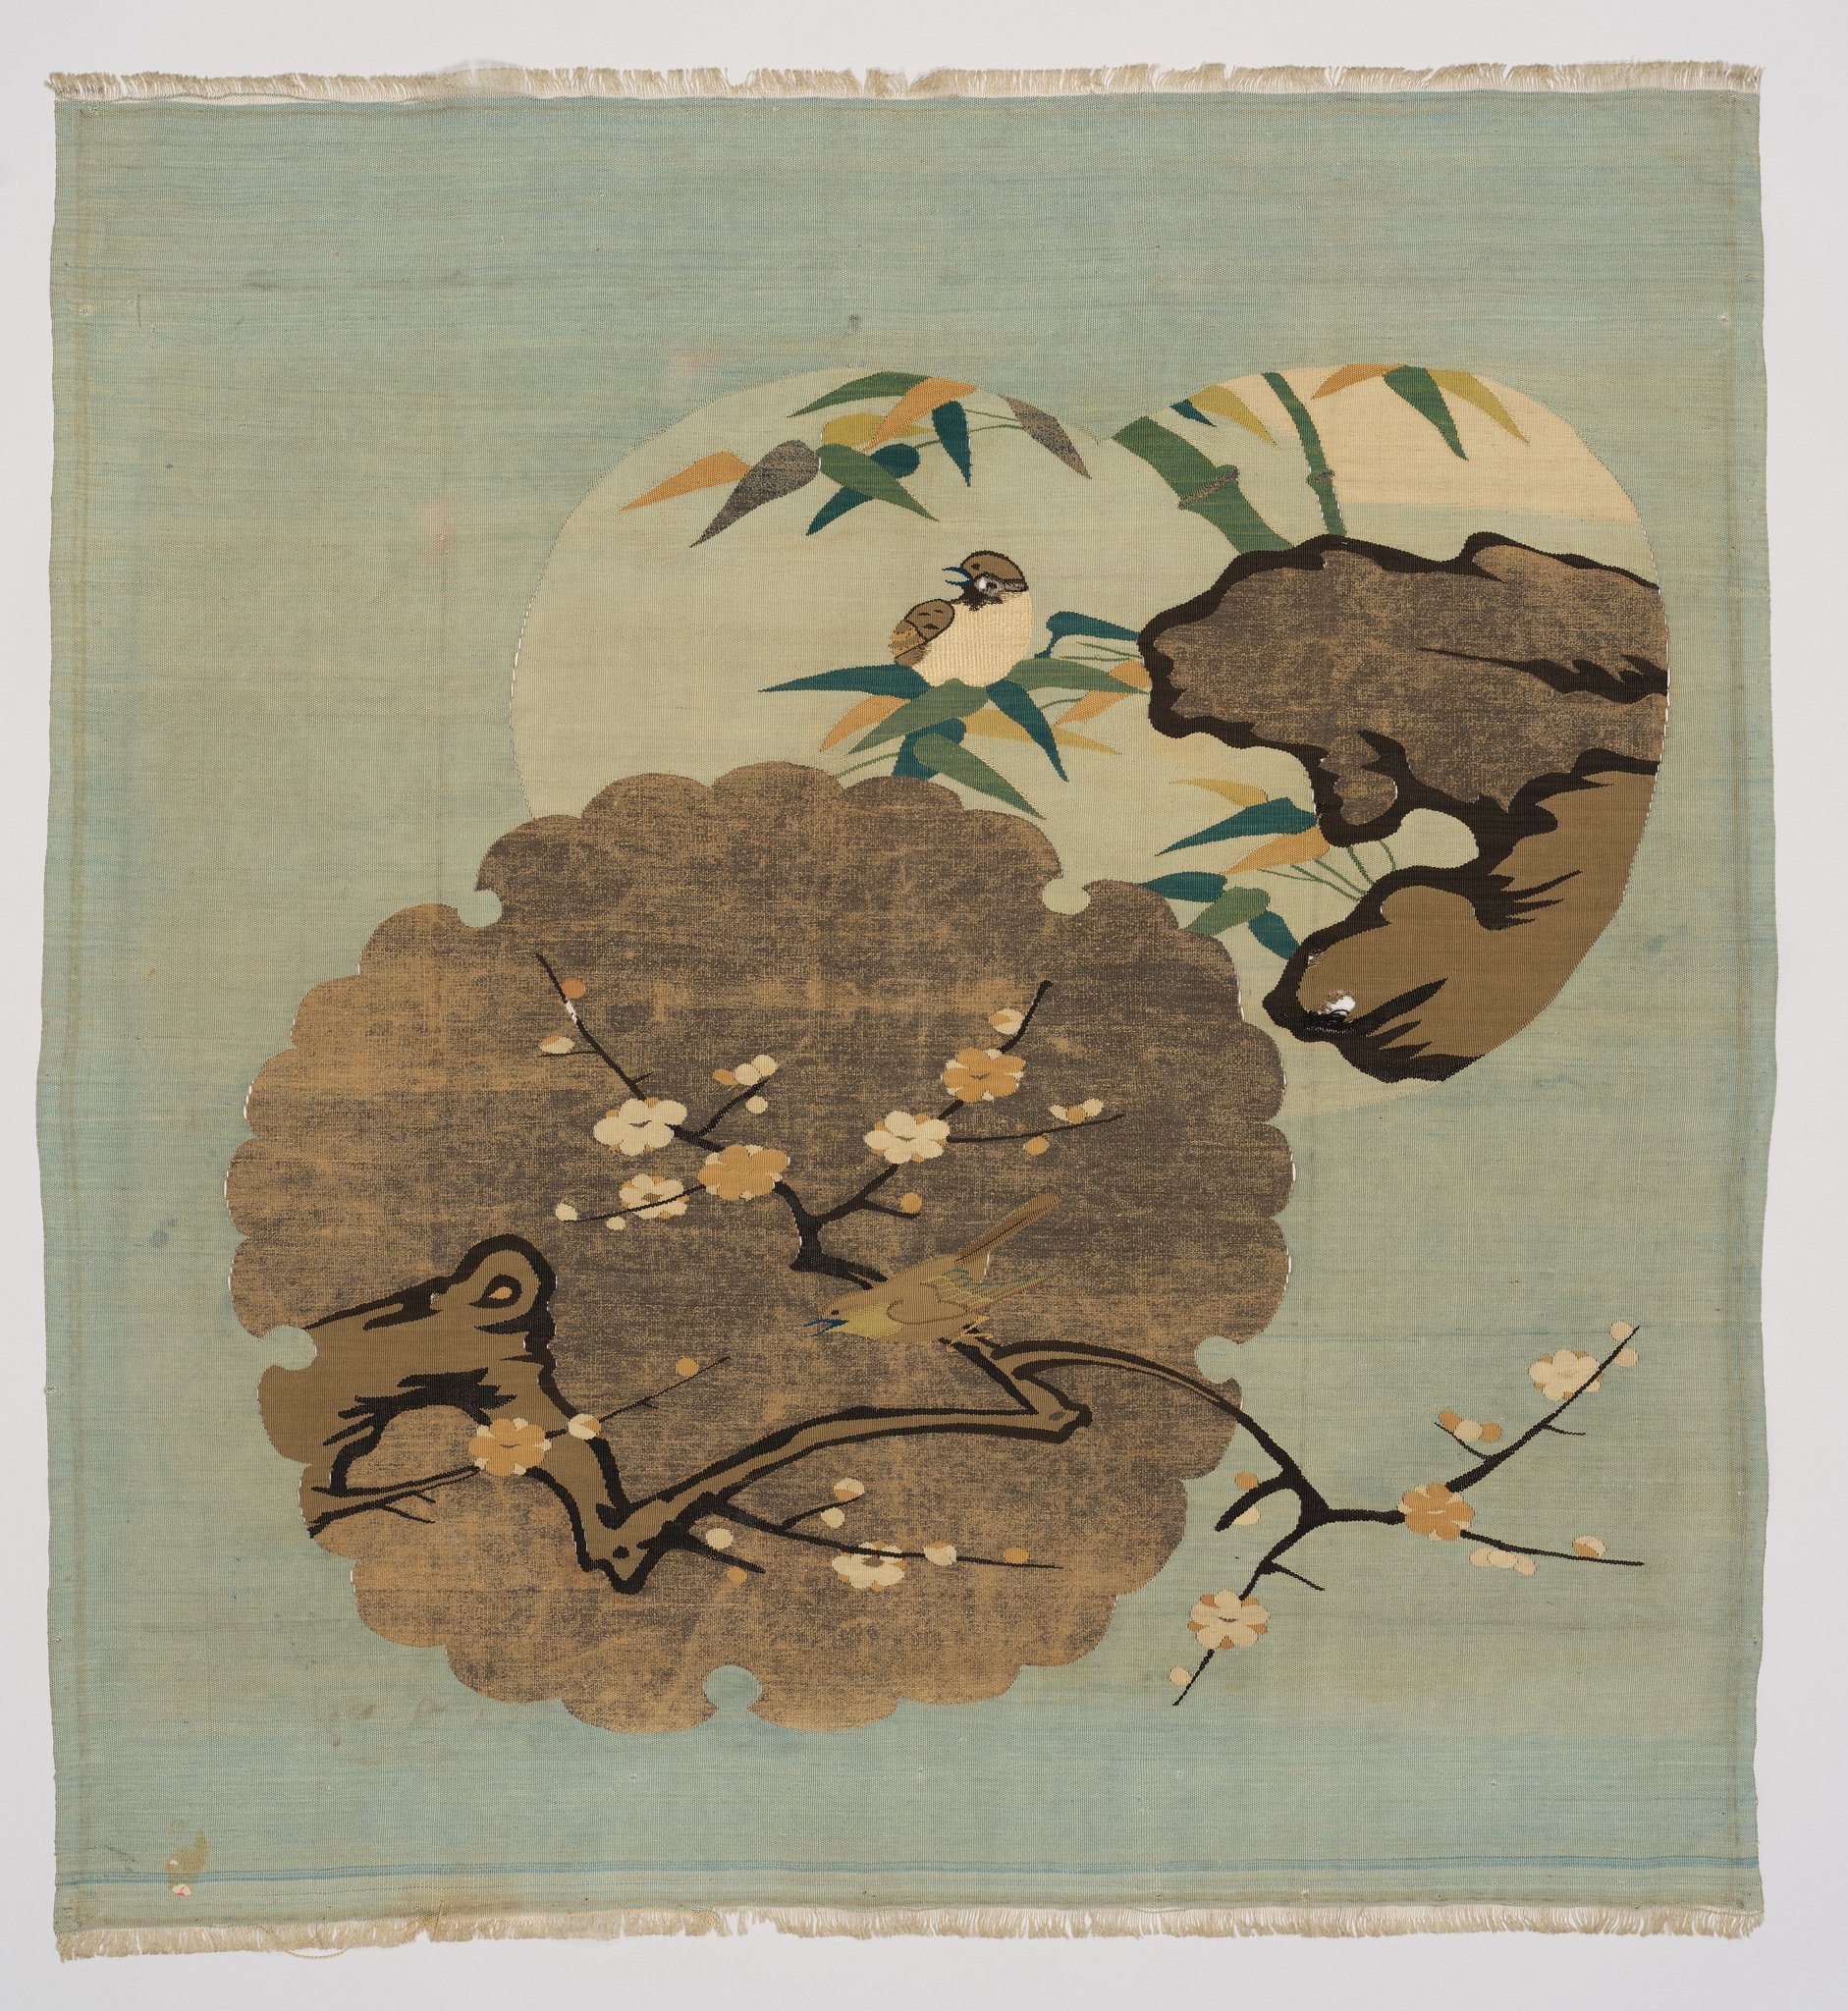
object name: fukusa gift wrapper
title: Fukusa (Gift Wrapper)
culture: japanese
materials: metal thread, silk